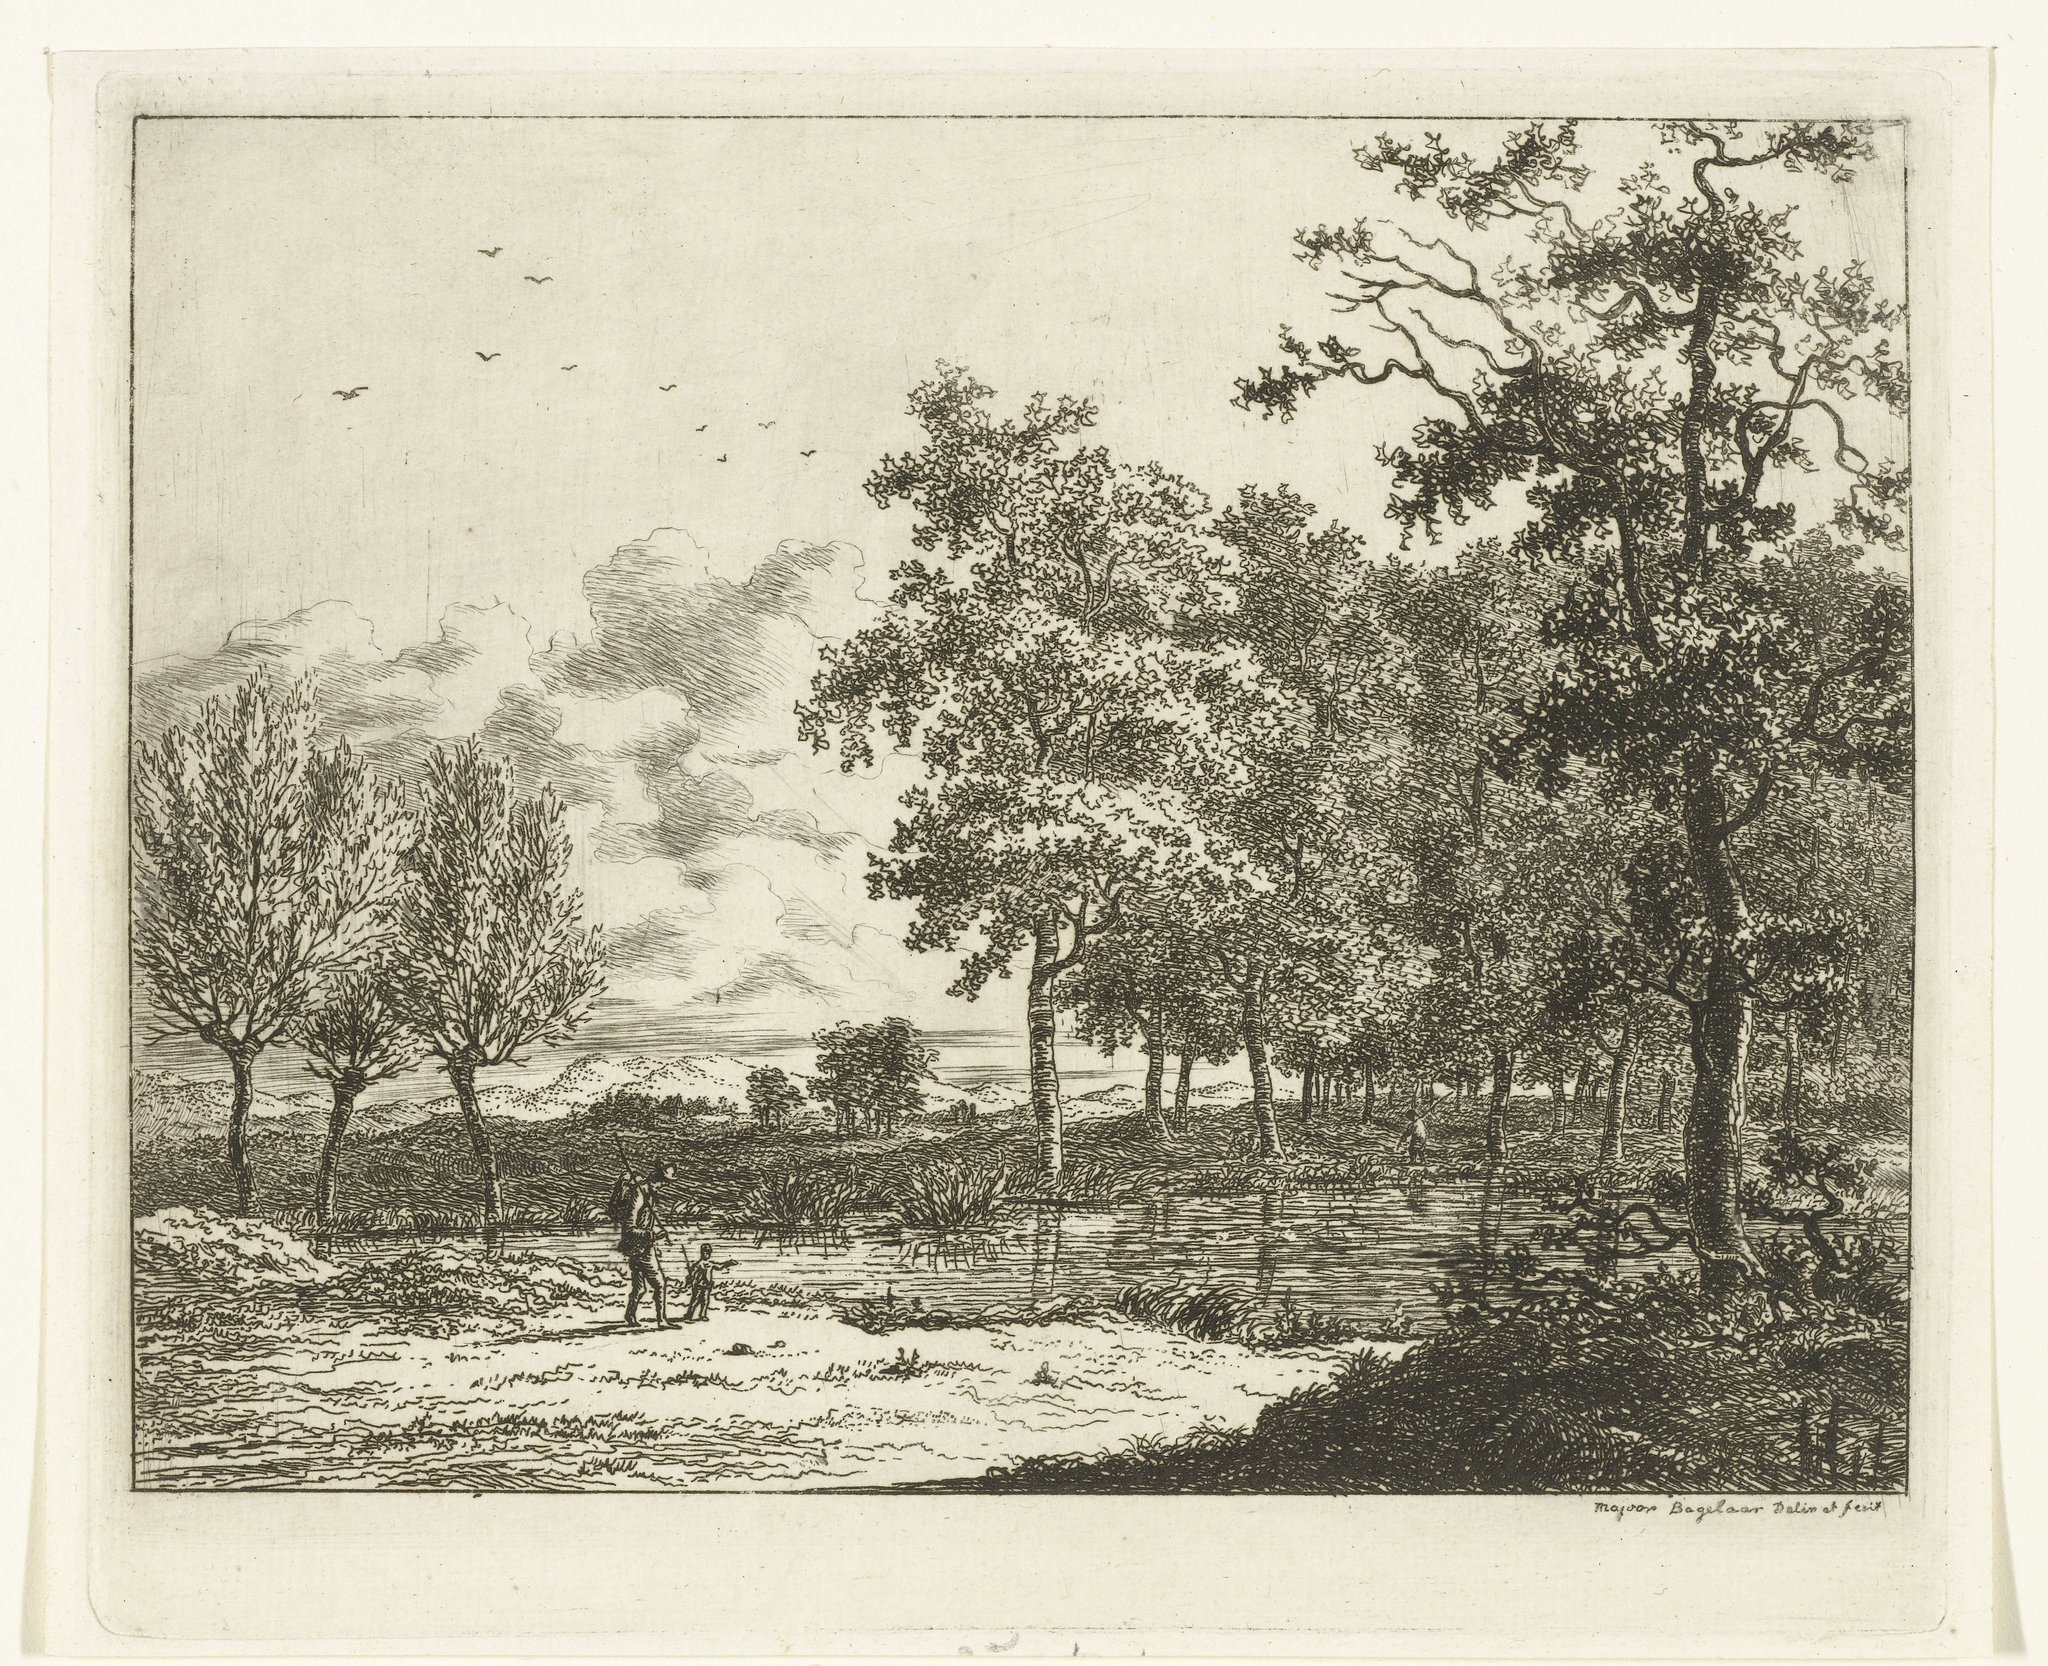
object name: print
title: Landschap met een man en een jongetje bij een rivier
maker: ernst willem jan bagelaar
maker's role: draughtsman, print maker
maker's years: 1775-1837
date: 1798-1837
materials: paper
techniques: drypoint, etching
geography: netherlands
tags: landscapes with waters, waterscapes, seascapes (in the temperate zone)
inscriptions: collector's mark: Lugt 2228